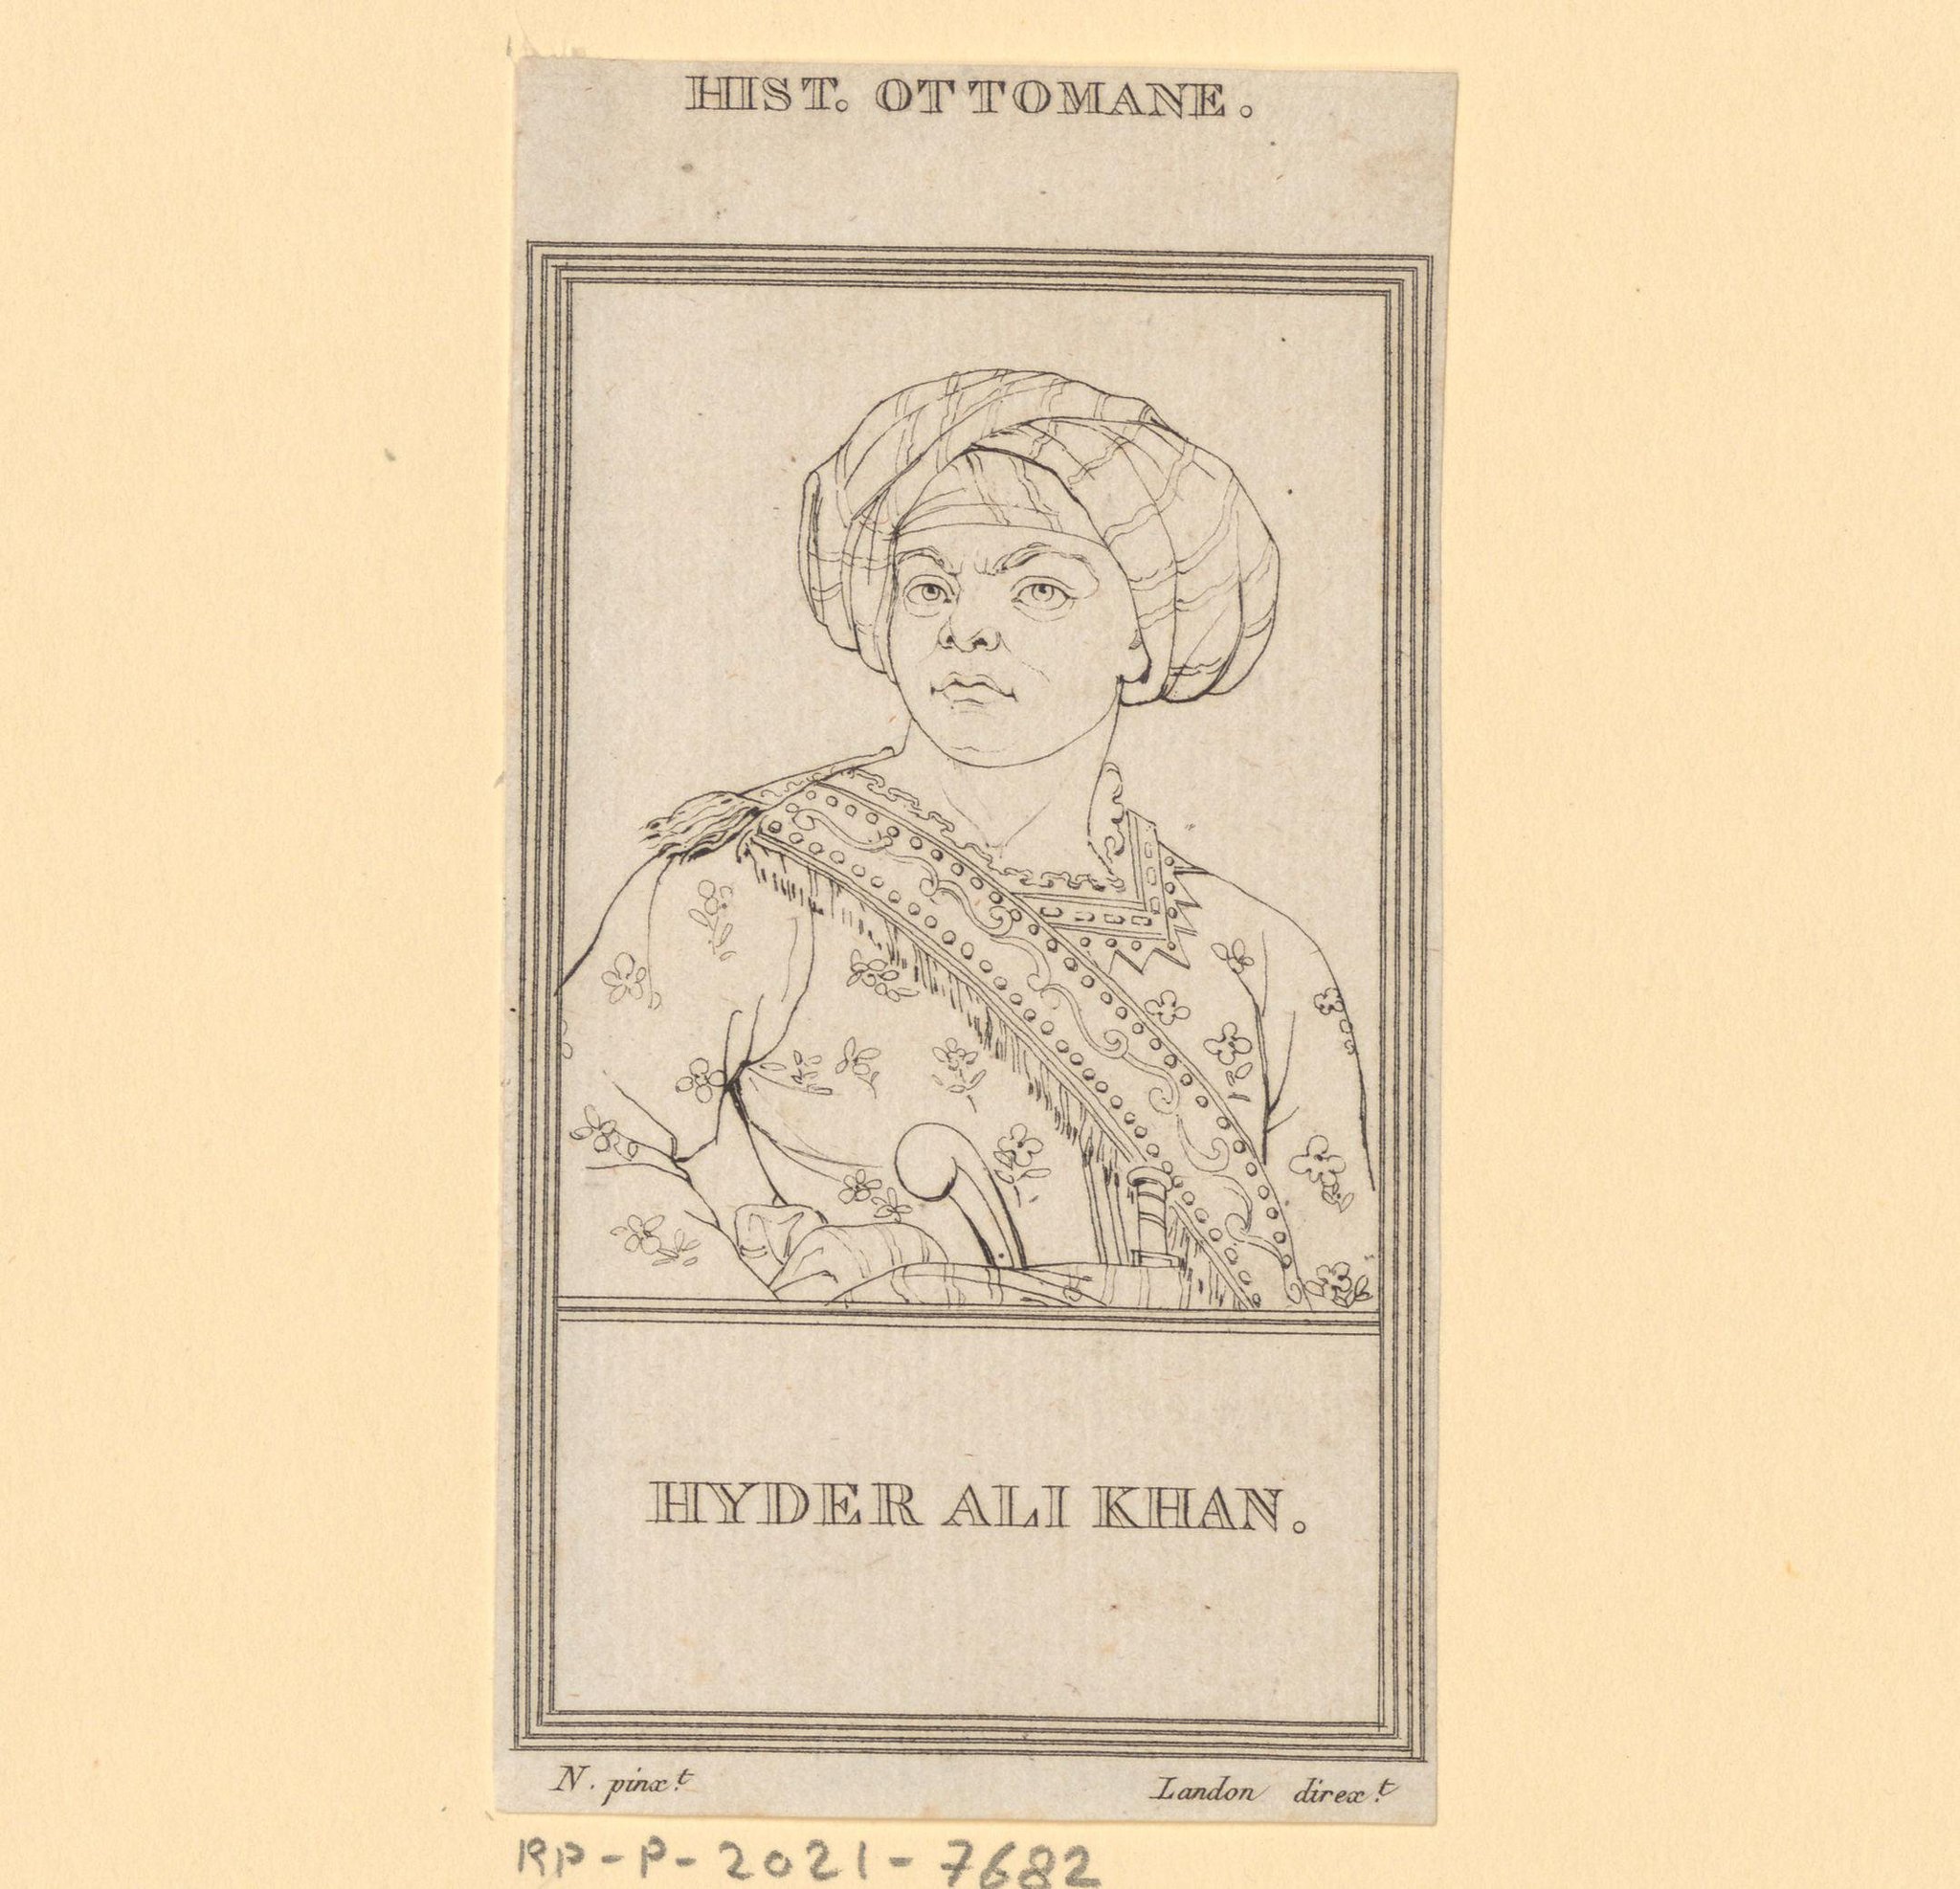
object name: book illustration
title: Portret van Haidar Ali, sultan van Mysore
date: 1805-1811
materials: paper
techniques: etching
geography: paris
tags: historical persons, ruler, sovereign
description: Prent uit: Galerie historique des hommes les plus célèbres (...). Parijs: Charles Paul Landon, 1805-1811.